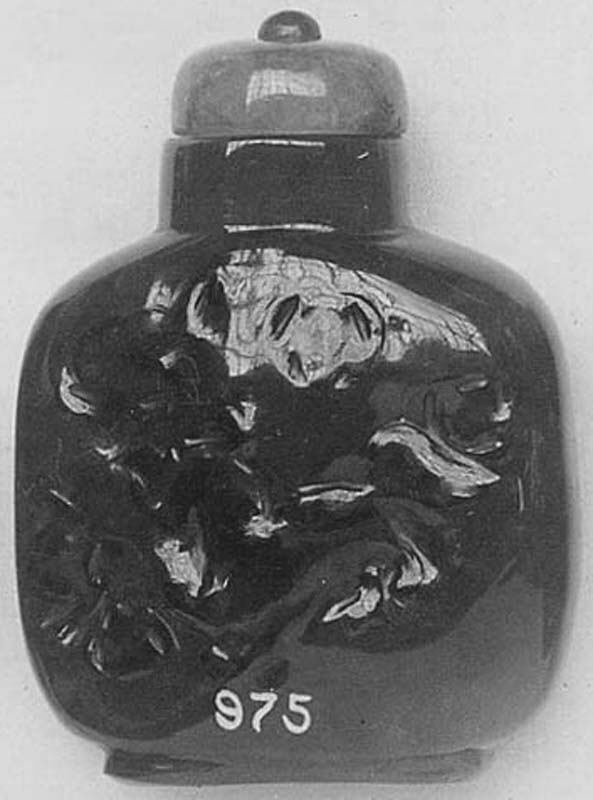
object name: snuff bottle with stopper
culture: chinese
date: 1701-1900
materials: stone, quartz